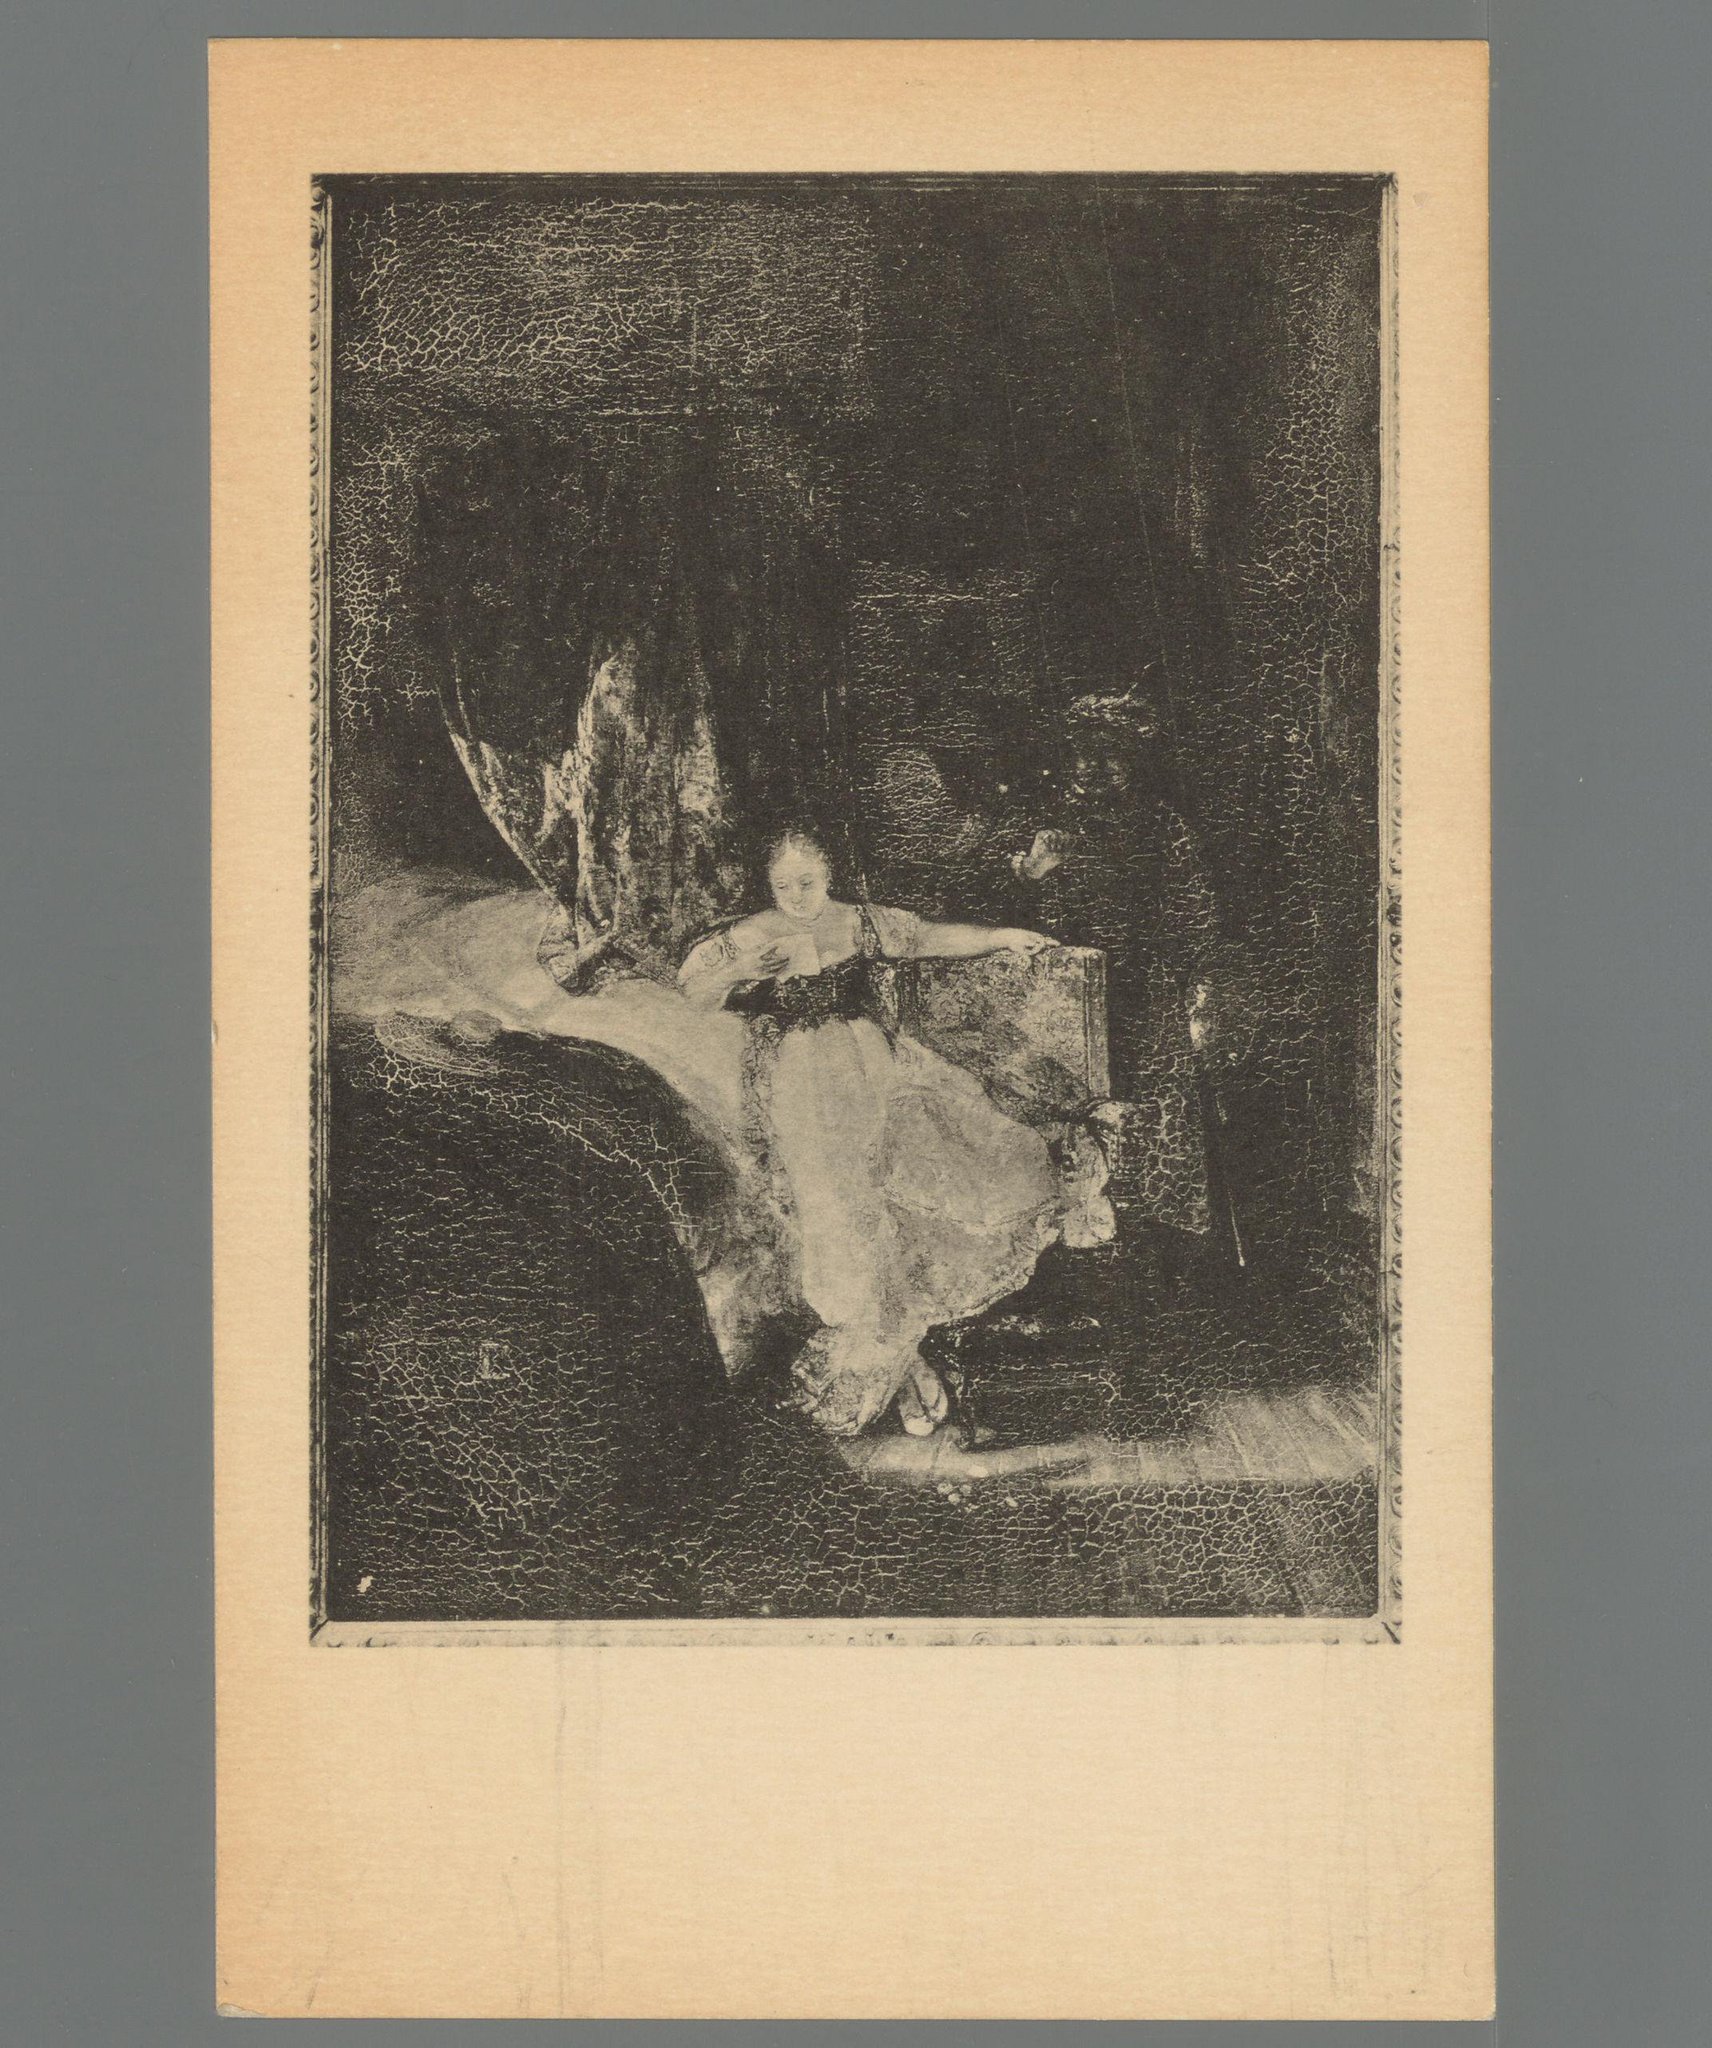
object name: photomechanical print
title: Rembrandt's Daughter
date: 1917-1950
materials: cardboard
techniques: photograph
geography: meriden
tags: adolescent, young woman, maiden, reading